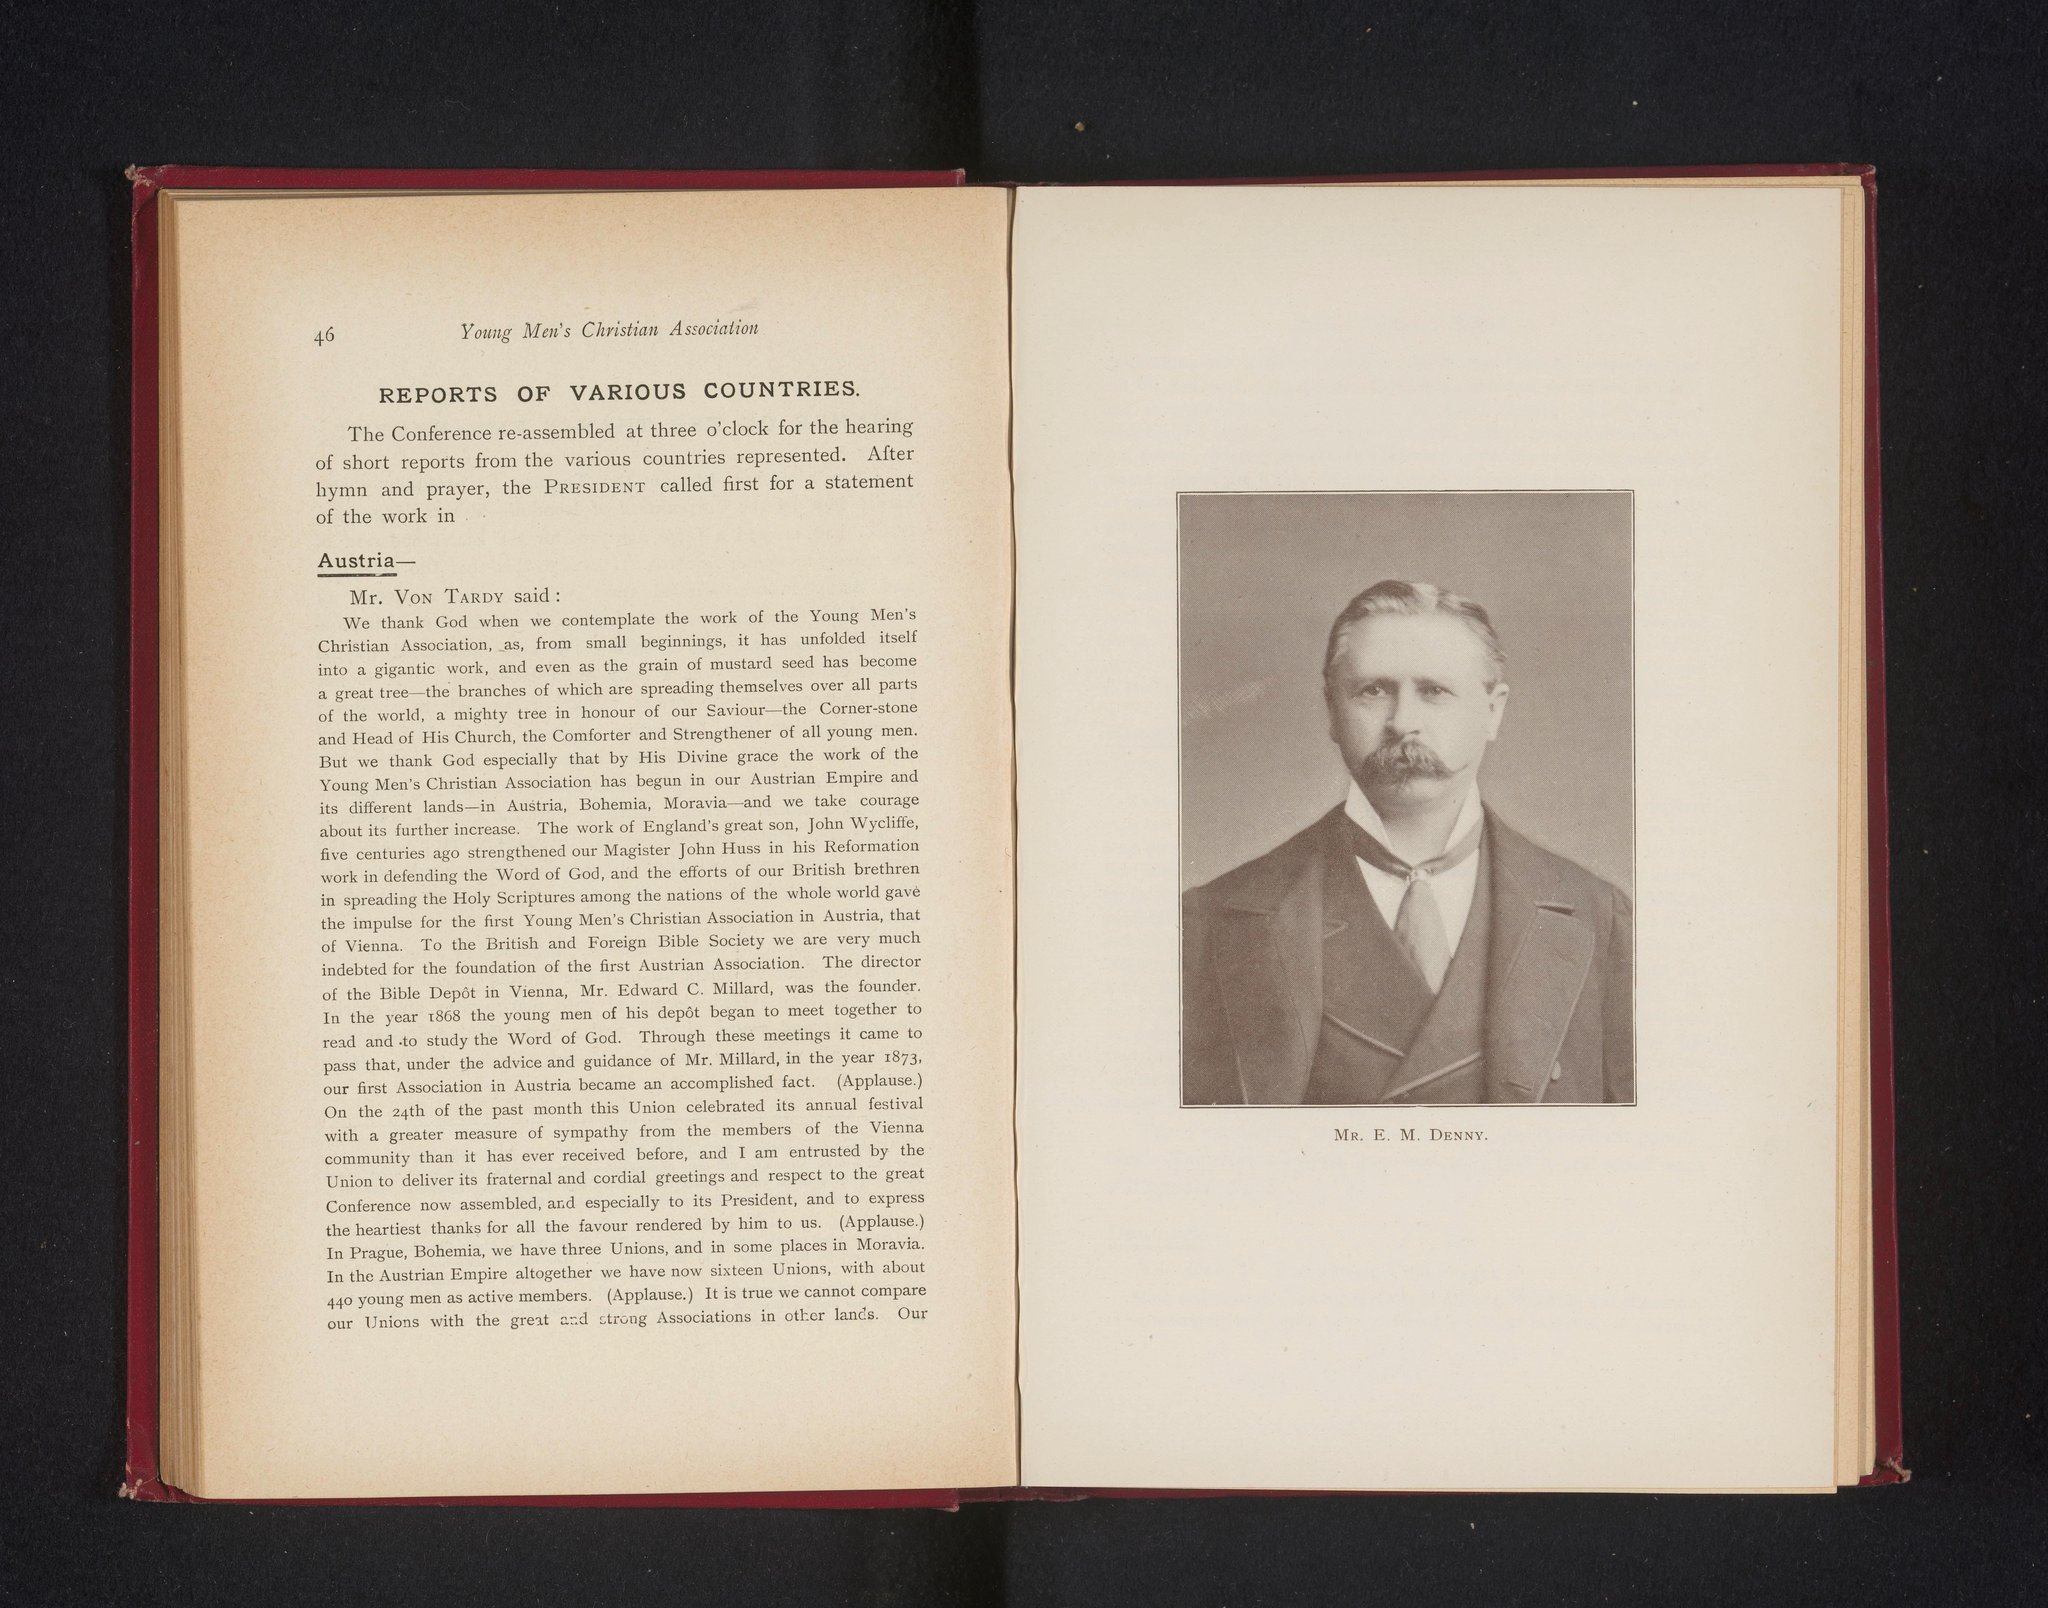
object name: photomechanical print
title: Portret van E.M. Denny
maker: Anonymous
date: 1890-1895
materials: paper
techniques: autotype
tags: historical persons